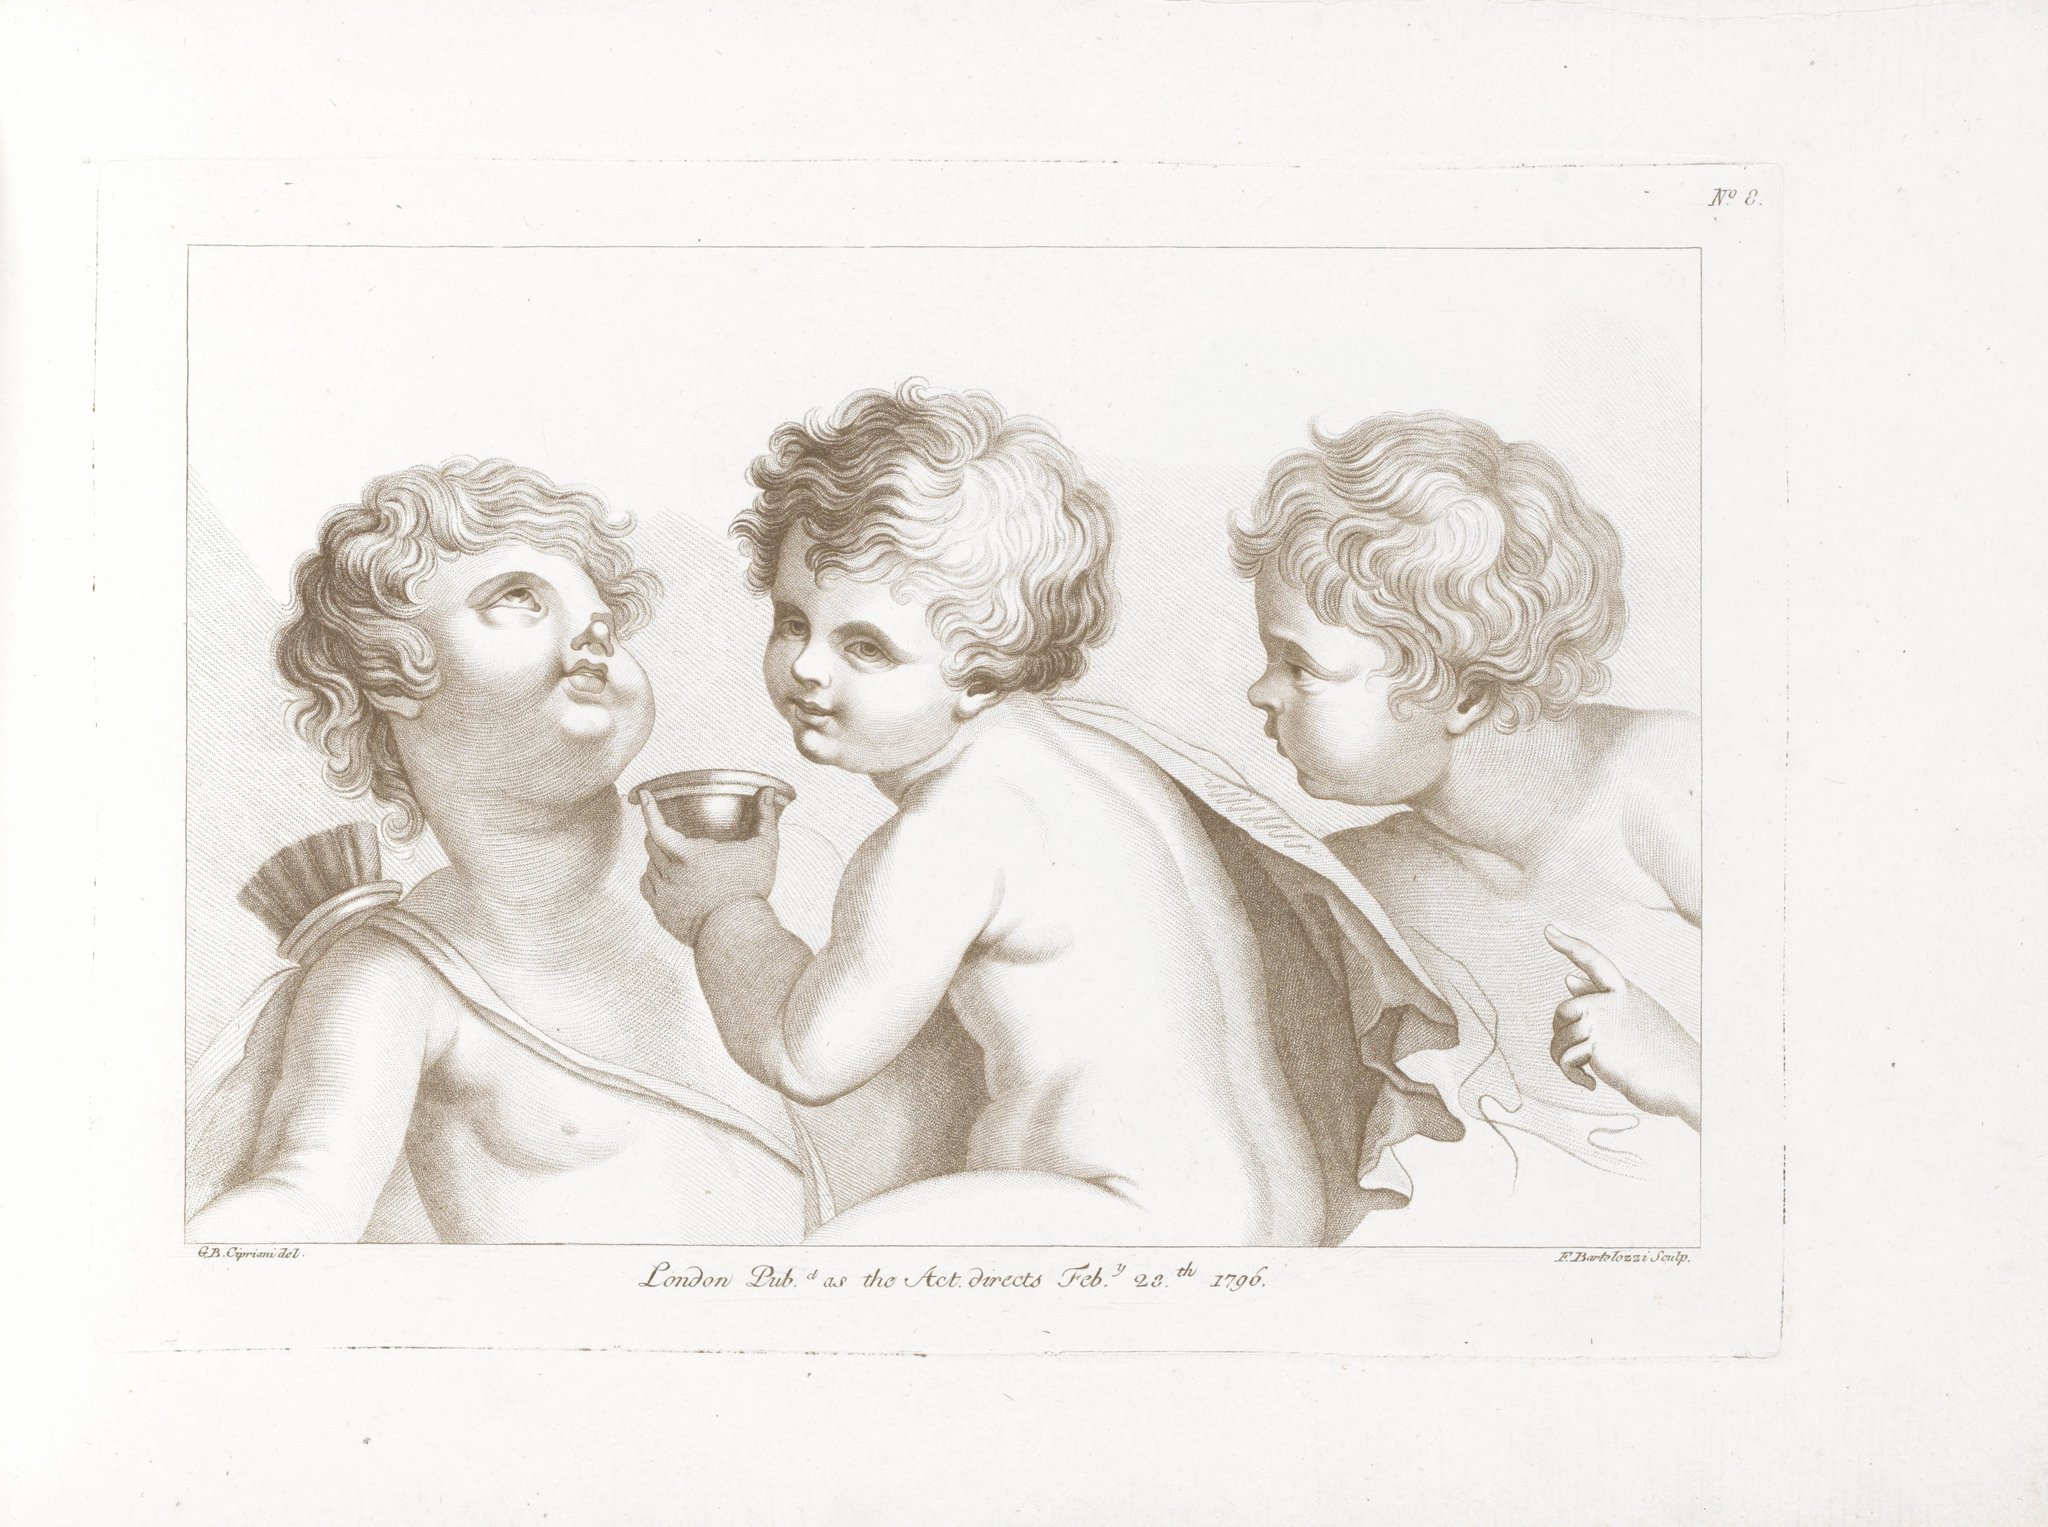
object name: print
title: Ciprianis beginselen van het tekenen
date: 1796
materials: paper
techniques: etching, engraving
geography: italy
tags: cupids: 'amores', 'amoretti', 'putti'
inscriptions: collector's mark: Lugt 2228, collector's mark: Lugt 2760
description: Drie putti naast elkaar. De middelste op de rug gezien.